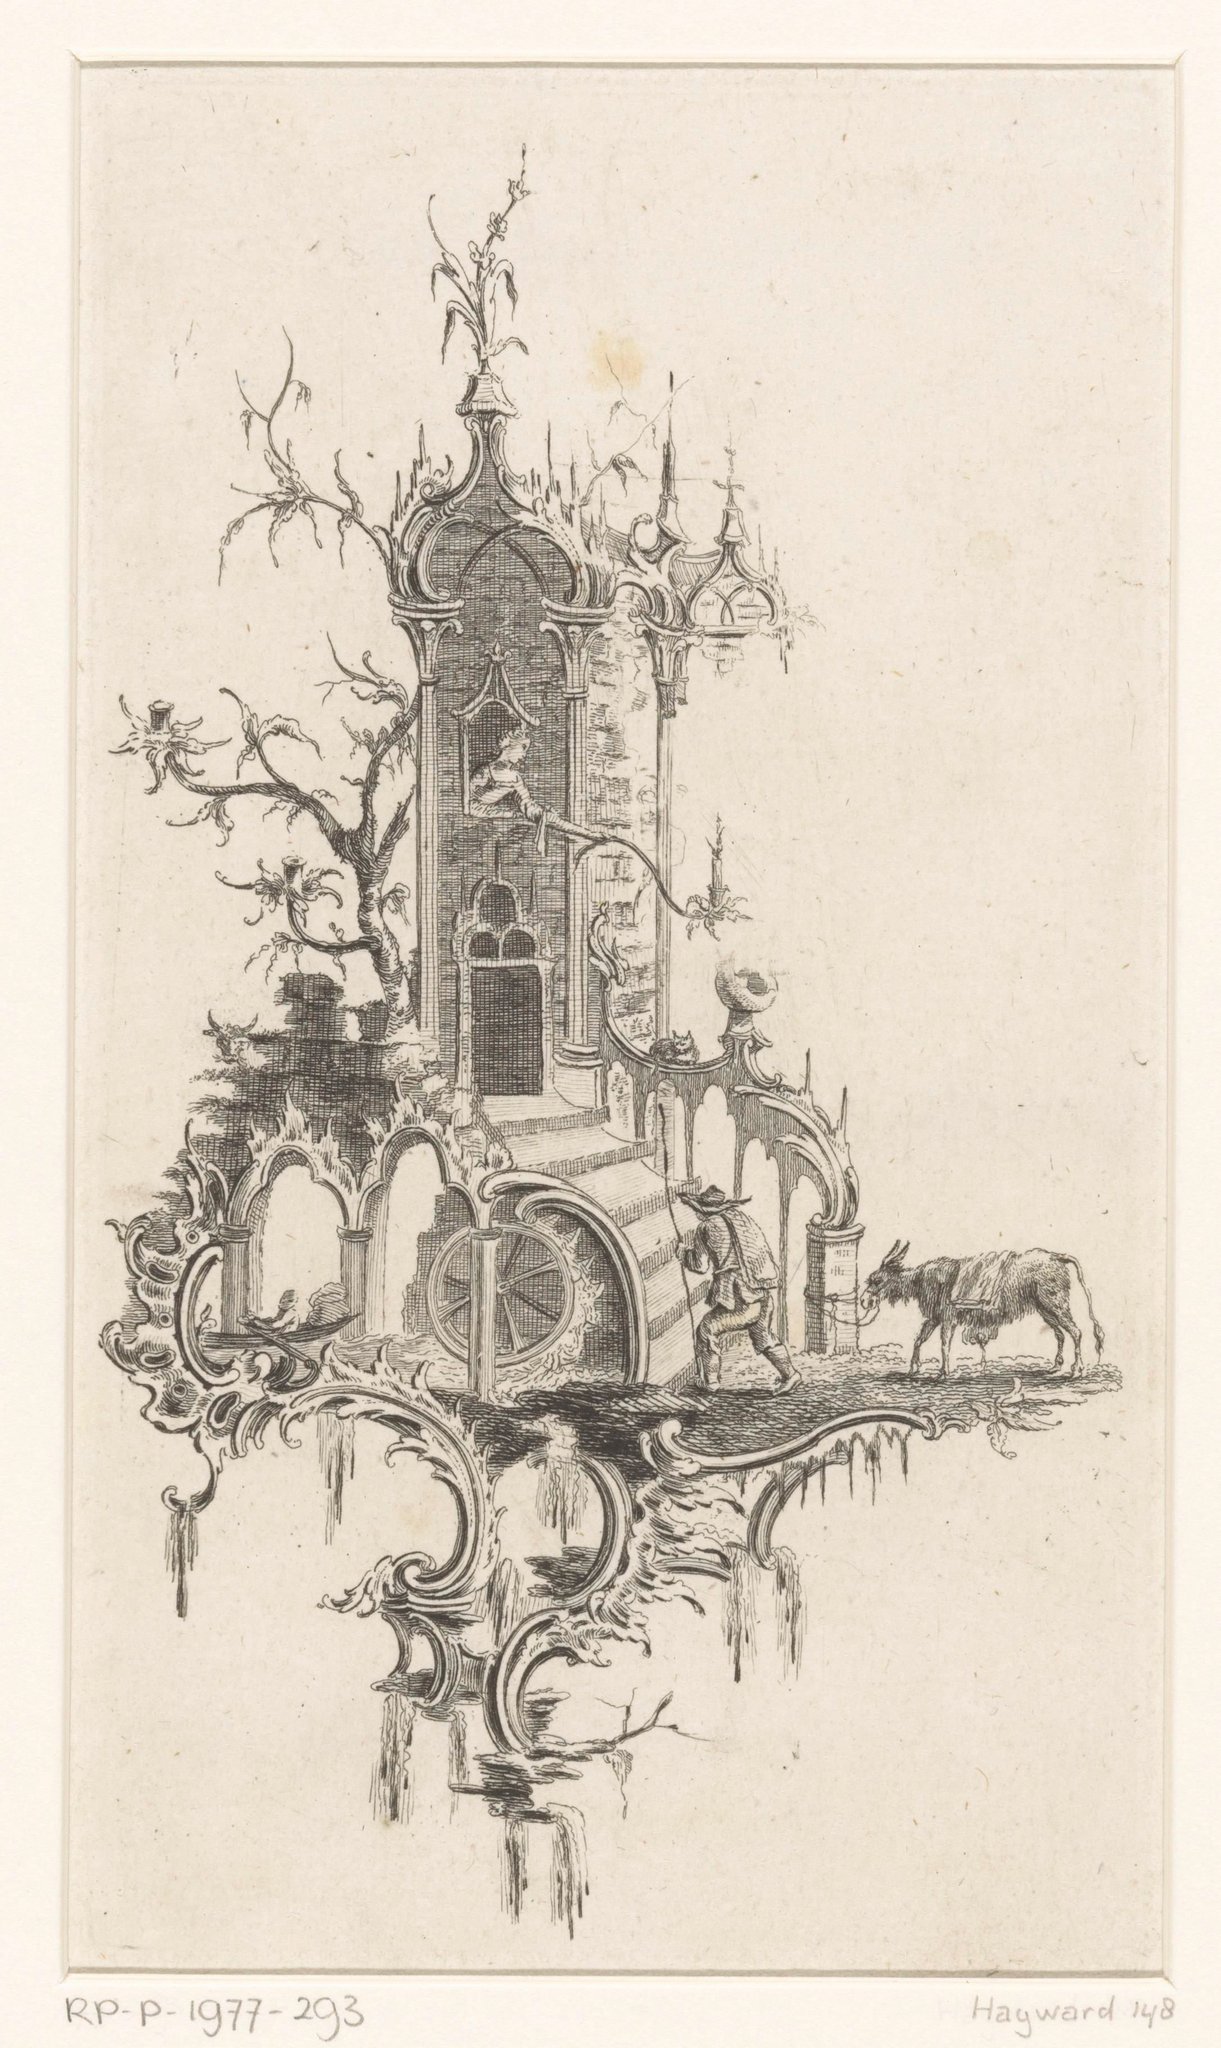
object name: ornament print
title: Girandole met man met ezel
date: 1755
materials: paper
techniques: engraving, etching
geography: london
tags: ass, donkey, chandelier, candelabrum, walking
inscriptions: collector's mark: Lugt 2228, collector's mark: Lugt 2760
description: Een geornamenteerde girandole met een vrouw die uit een raam van een gebouw hangt, daaronder een watermolen en links een boot. Rechts heeft een man zijn ezel vastgebonden, hij loopt de trap op.